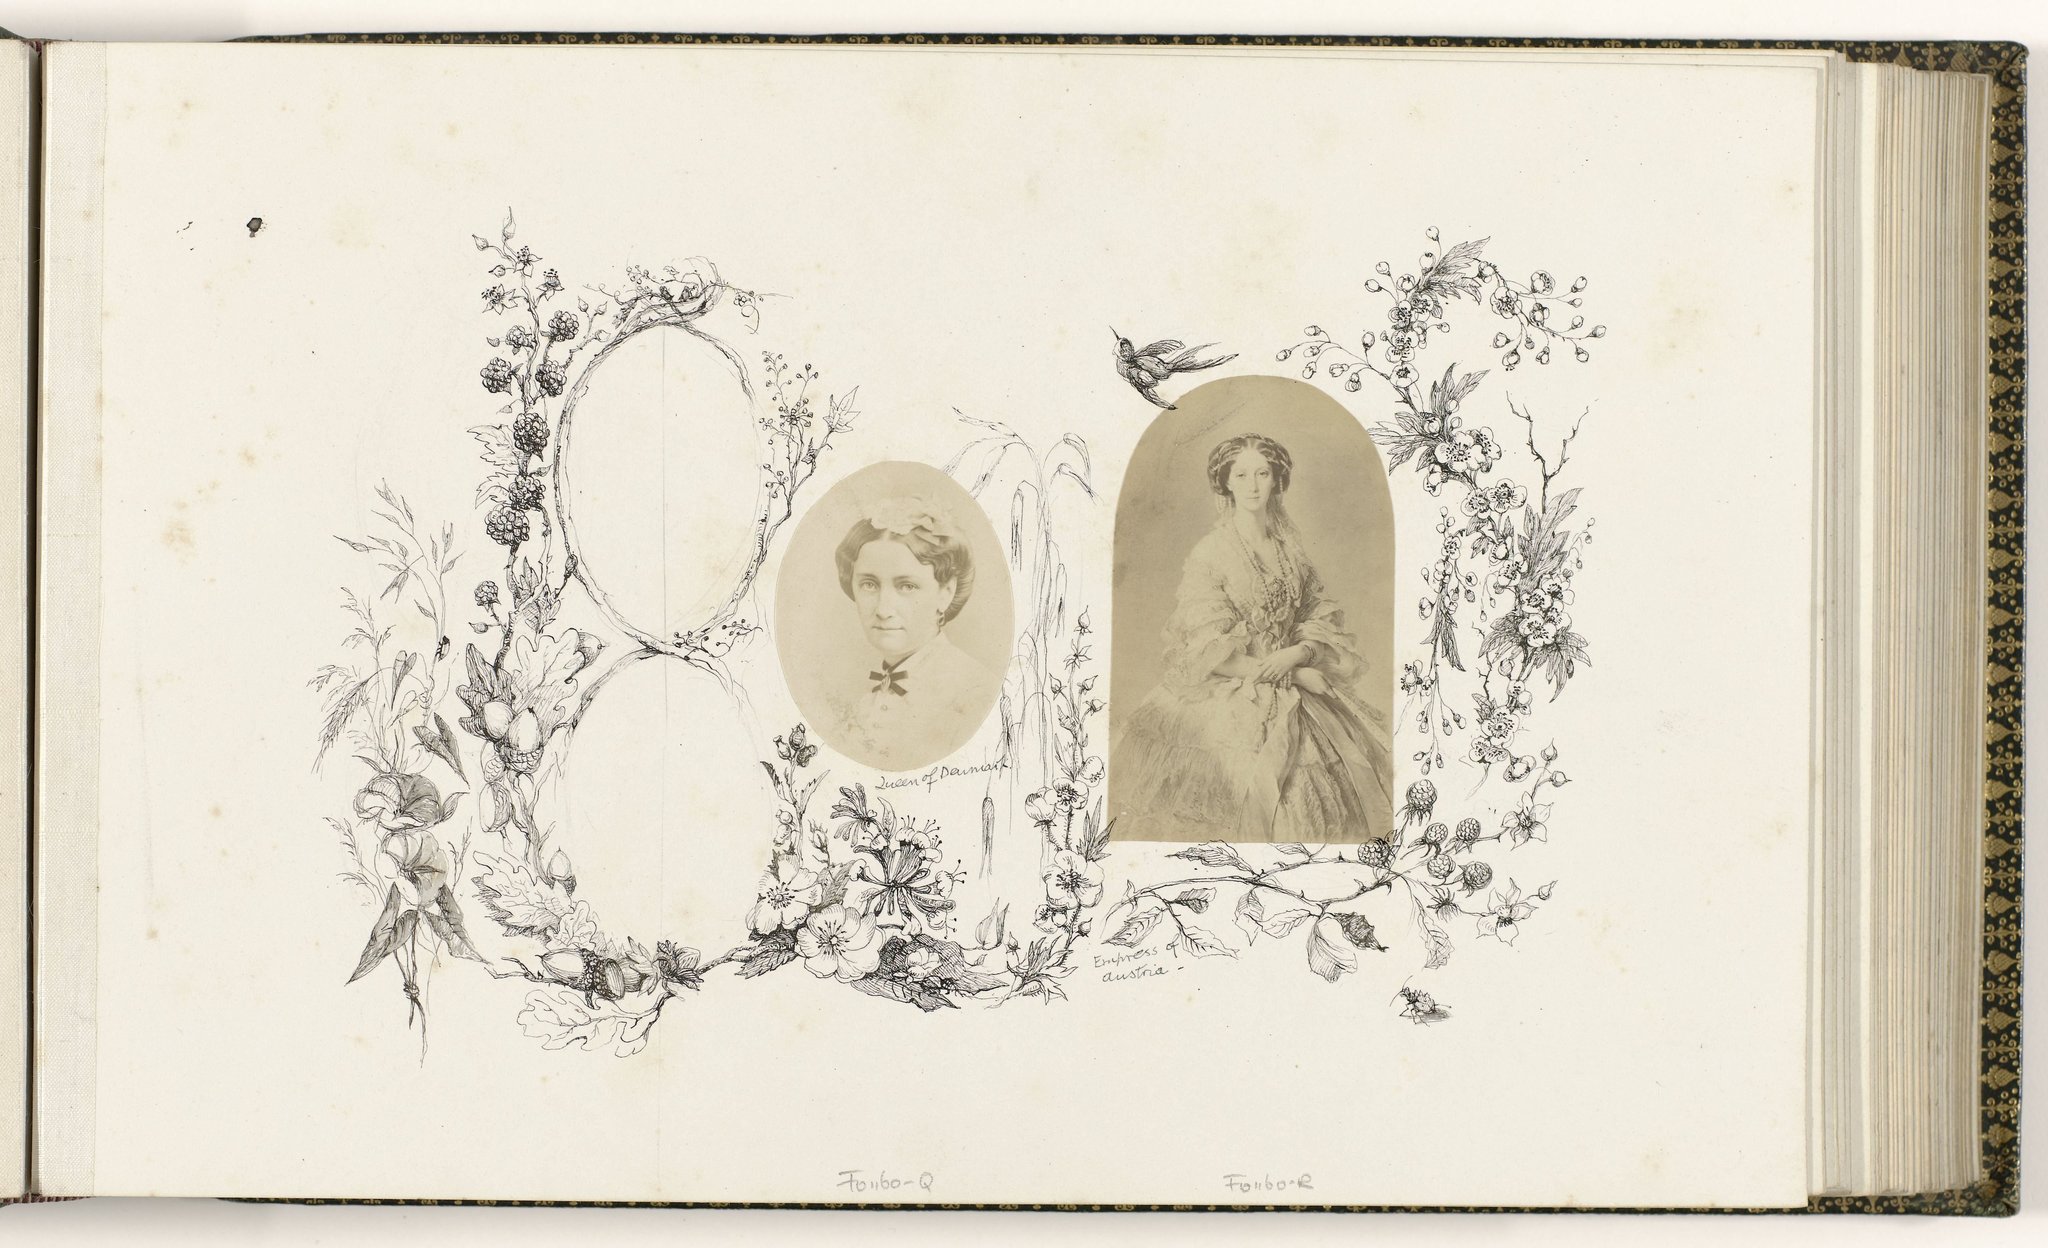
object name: album leaf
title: Fotoreproductie van een geschilderd portret van Maria Alexandrovna, keizerin van Rusland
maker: Anonymous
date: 1870-1875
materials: paper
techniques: albumen print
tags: historical persons - bb - woman, queen, empress, etc. (wife of a ruler), picture, painting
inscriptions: inscription: ‘Empress of/ Austria’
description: Het portret van Maria Alexandrovna door Winterhalter bevindt zich in de Hermitage te Sint-Petersburg. De annotatie 'Empress of Austria' is incorrect.